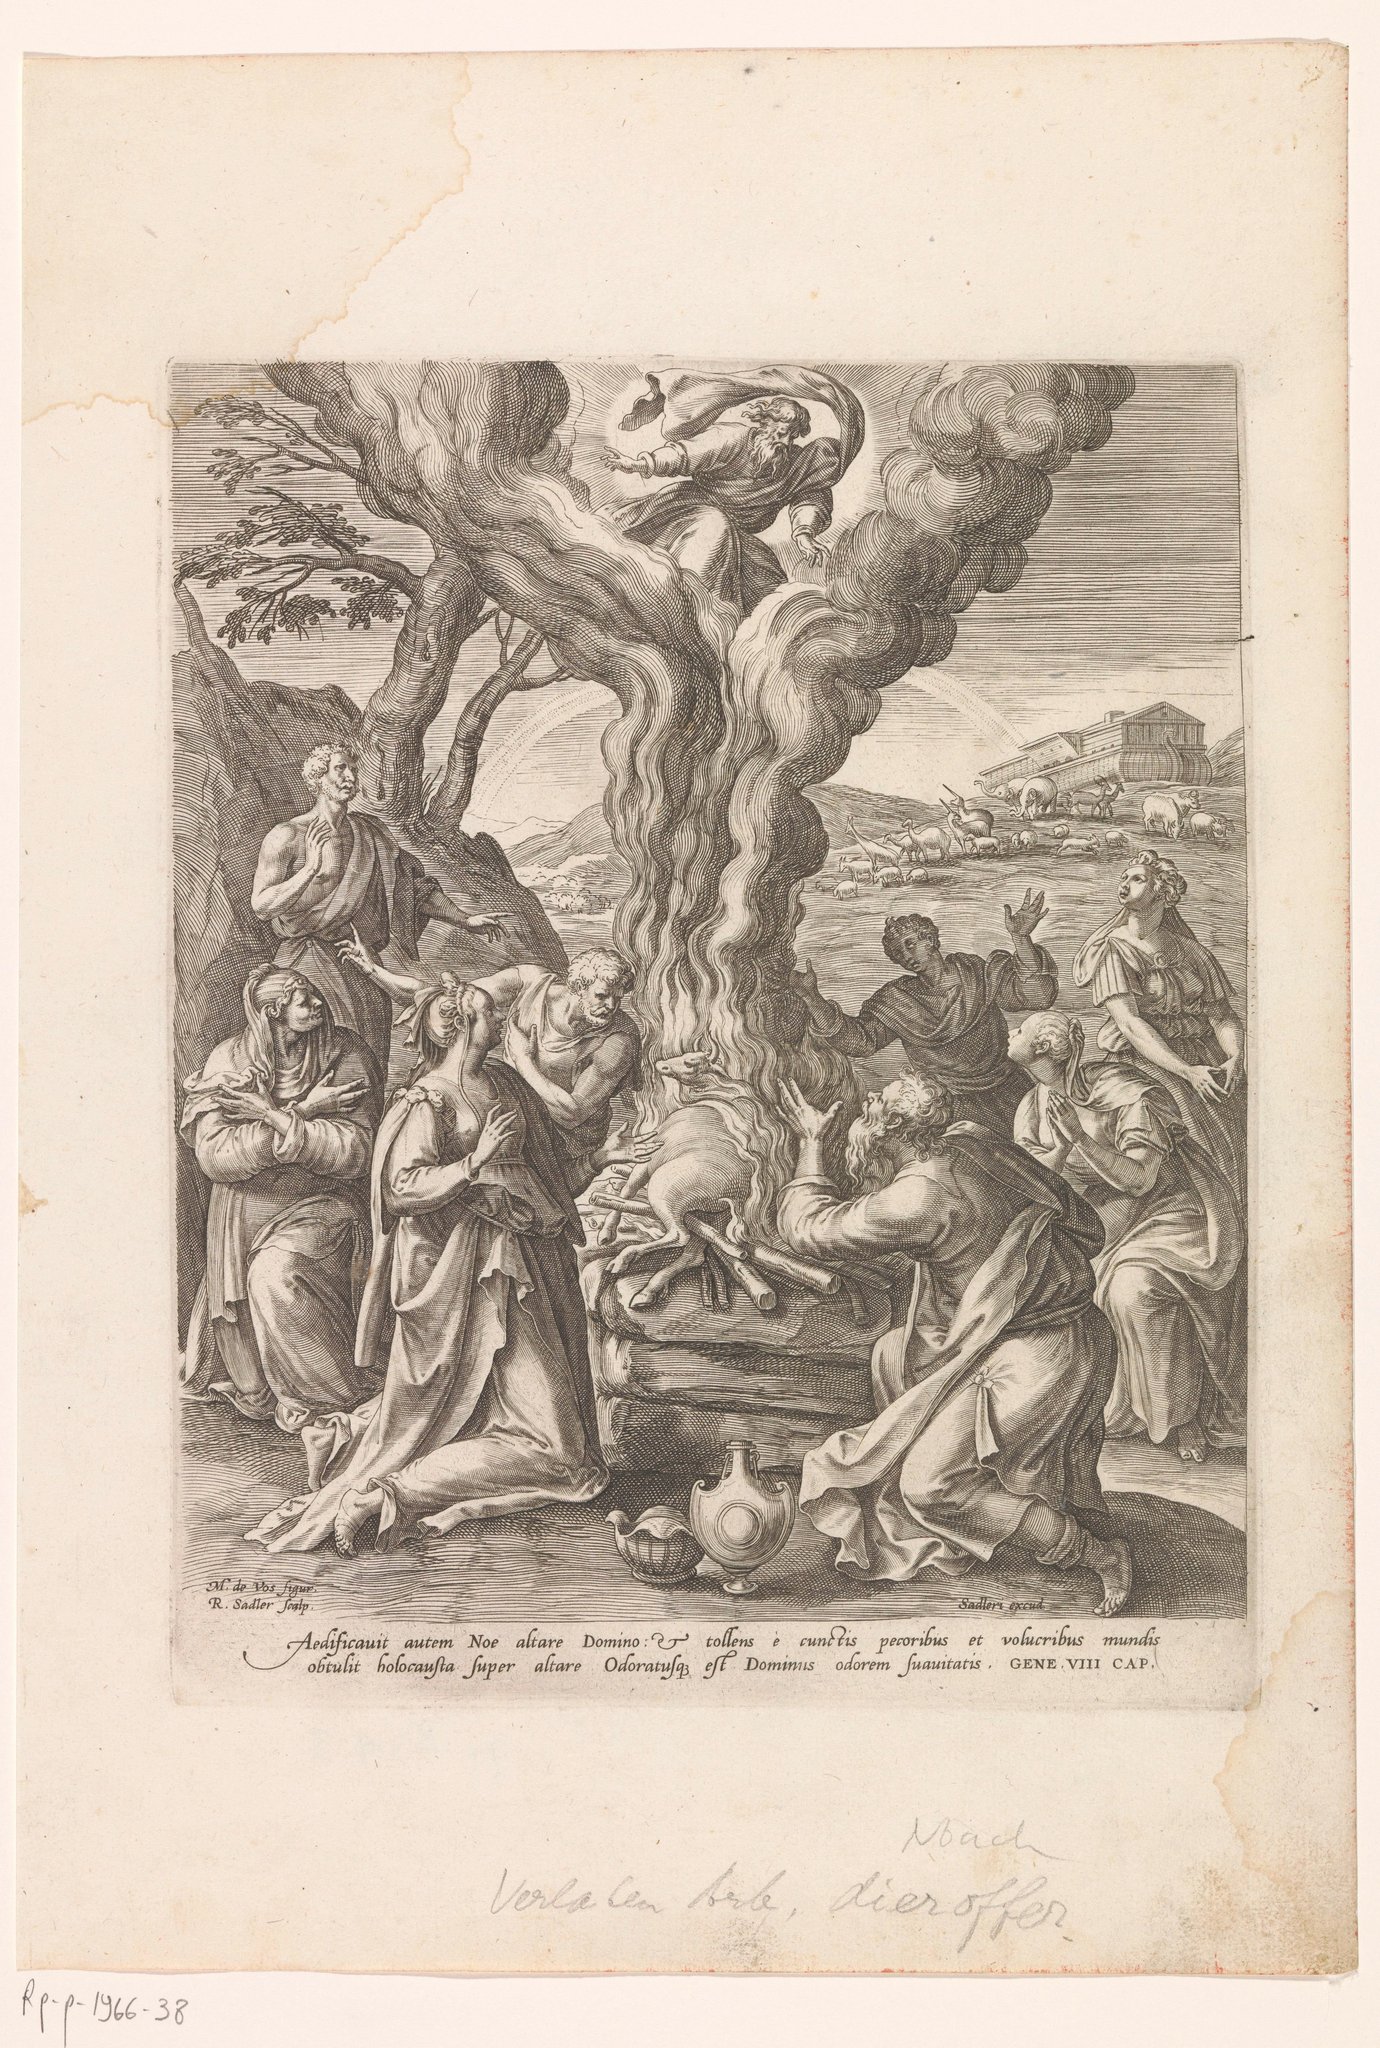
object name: print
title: Offer van Noach na de zondvloed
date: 1570-1632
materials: paper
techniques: engraving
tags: god the father as bearded old man, usually with crown or tiara or sceptre and/or globe, noah's sacrifice; various animals are offered, possibly a lamb, a dove and a ram (often combined with the rainbow of the covenant)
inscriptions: collector's mark: Lugt 2228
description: Na de zondvloed offeren Noach en zijn familie een stier op een altaar. God keurt het offer goed en verschijnt aan de hemel. De vierde prent uit een negendelige serie met scènes uit het Oude Testament.